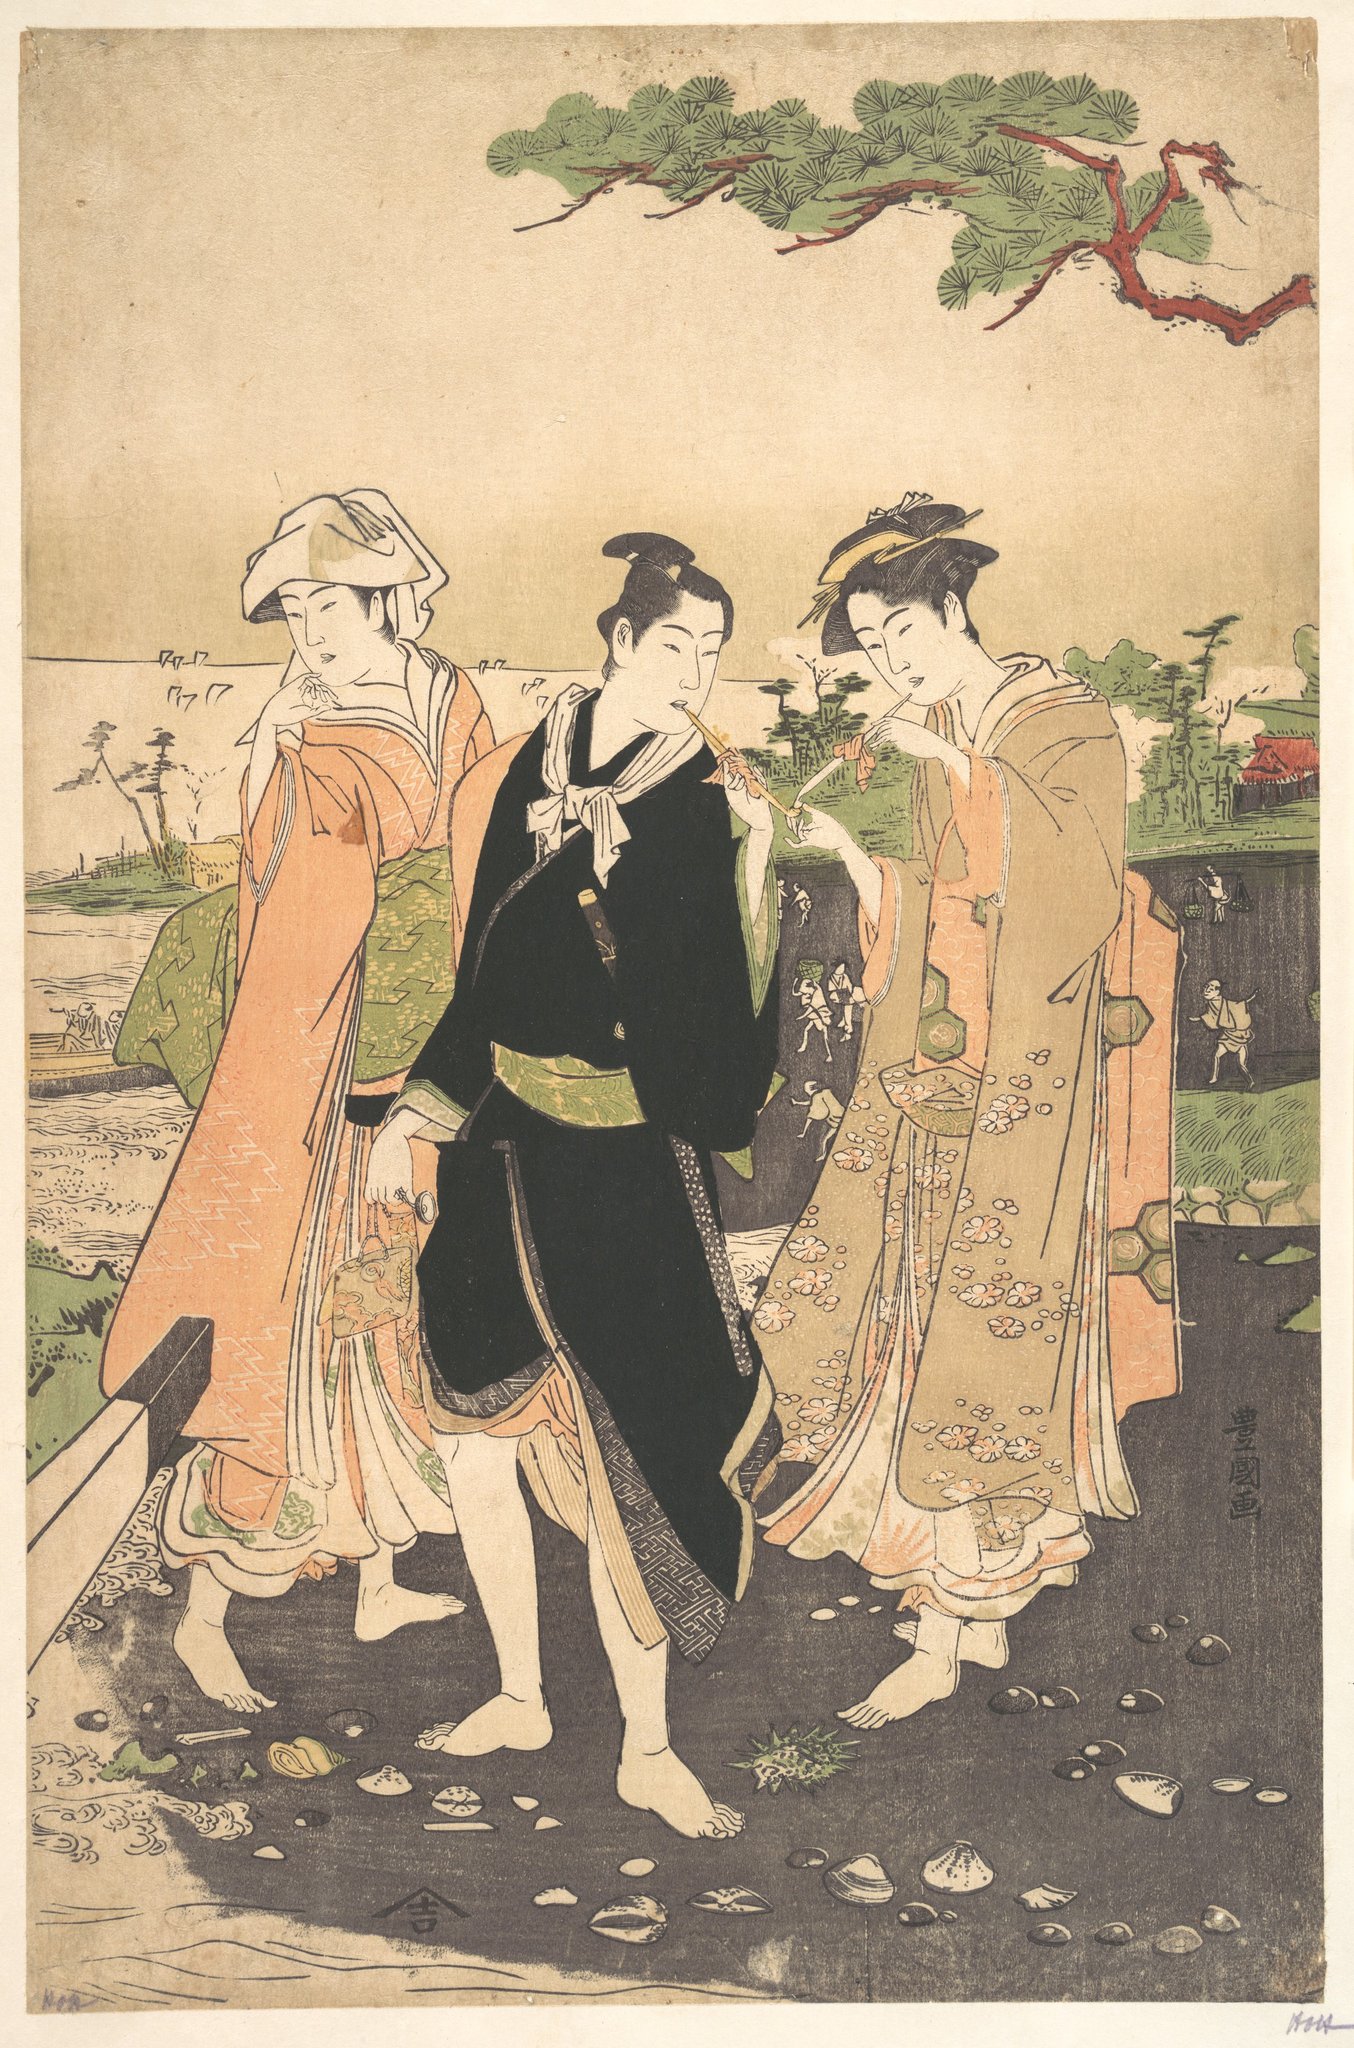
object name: print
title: Along the Seashore at Futami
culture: japanese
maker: utagawa toyokuni i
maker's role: artist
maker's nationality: japanese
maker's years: 1769-1825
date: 1769-1825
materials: ink, paper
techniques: woodblock print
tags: men,women,smoking